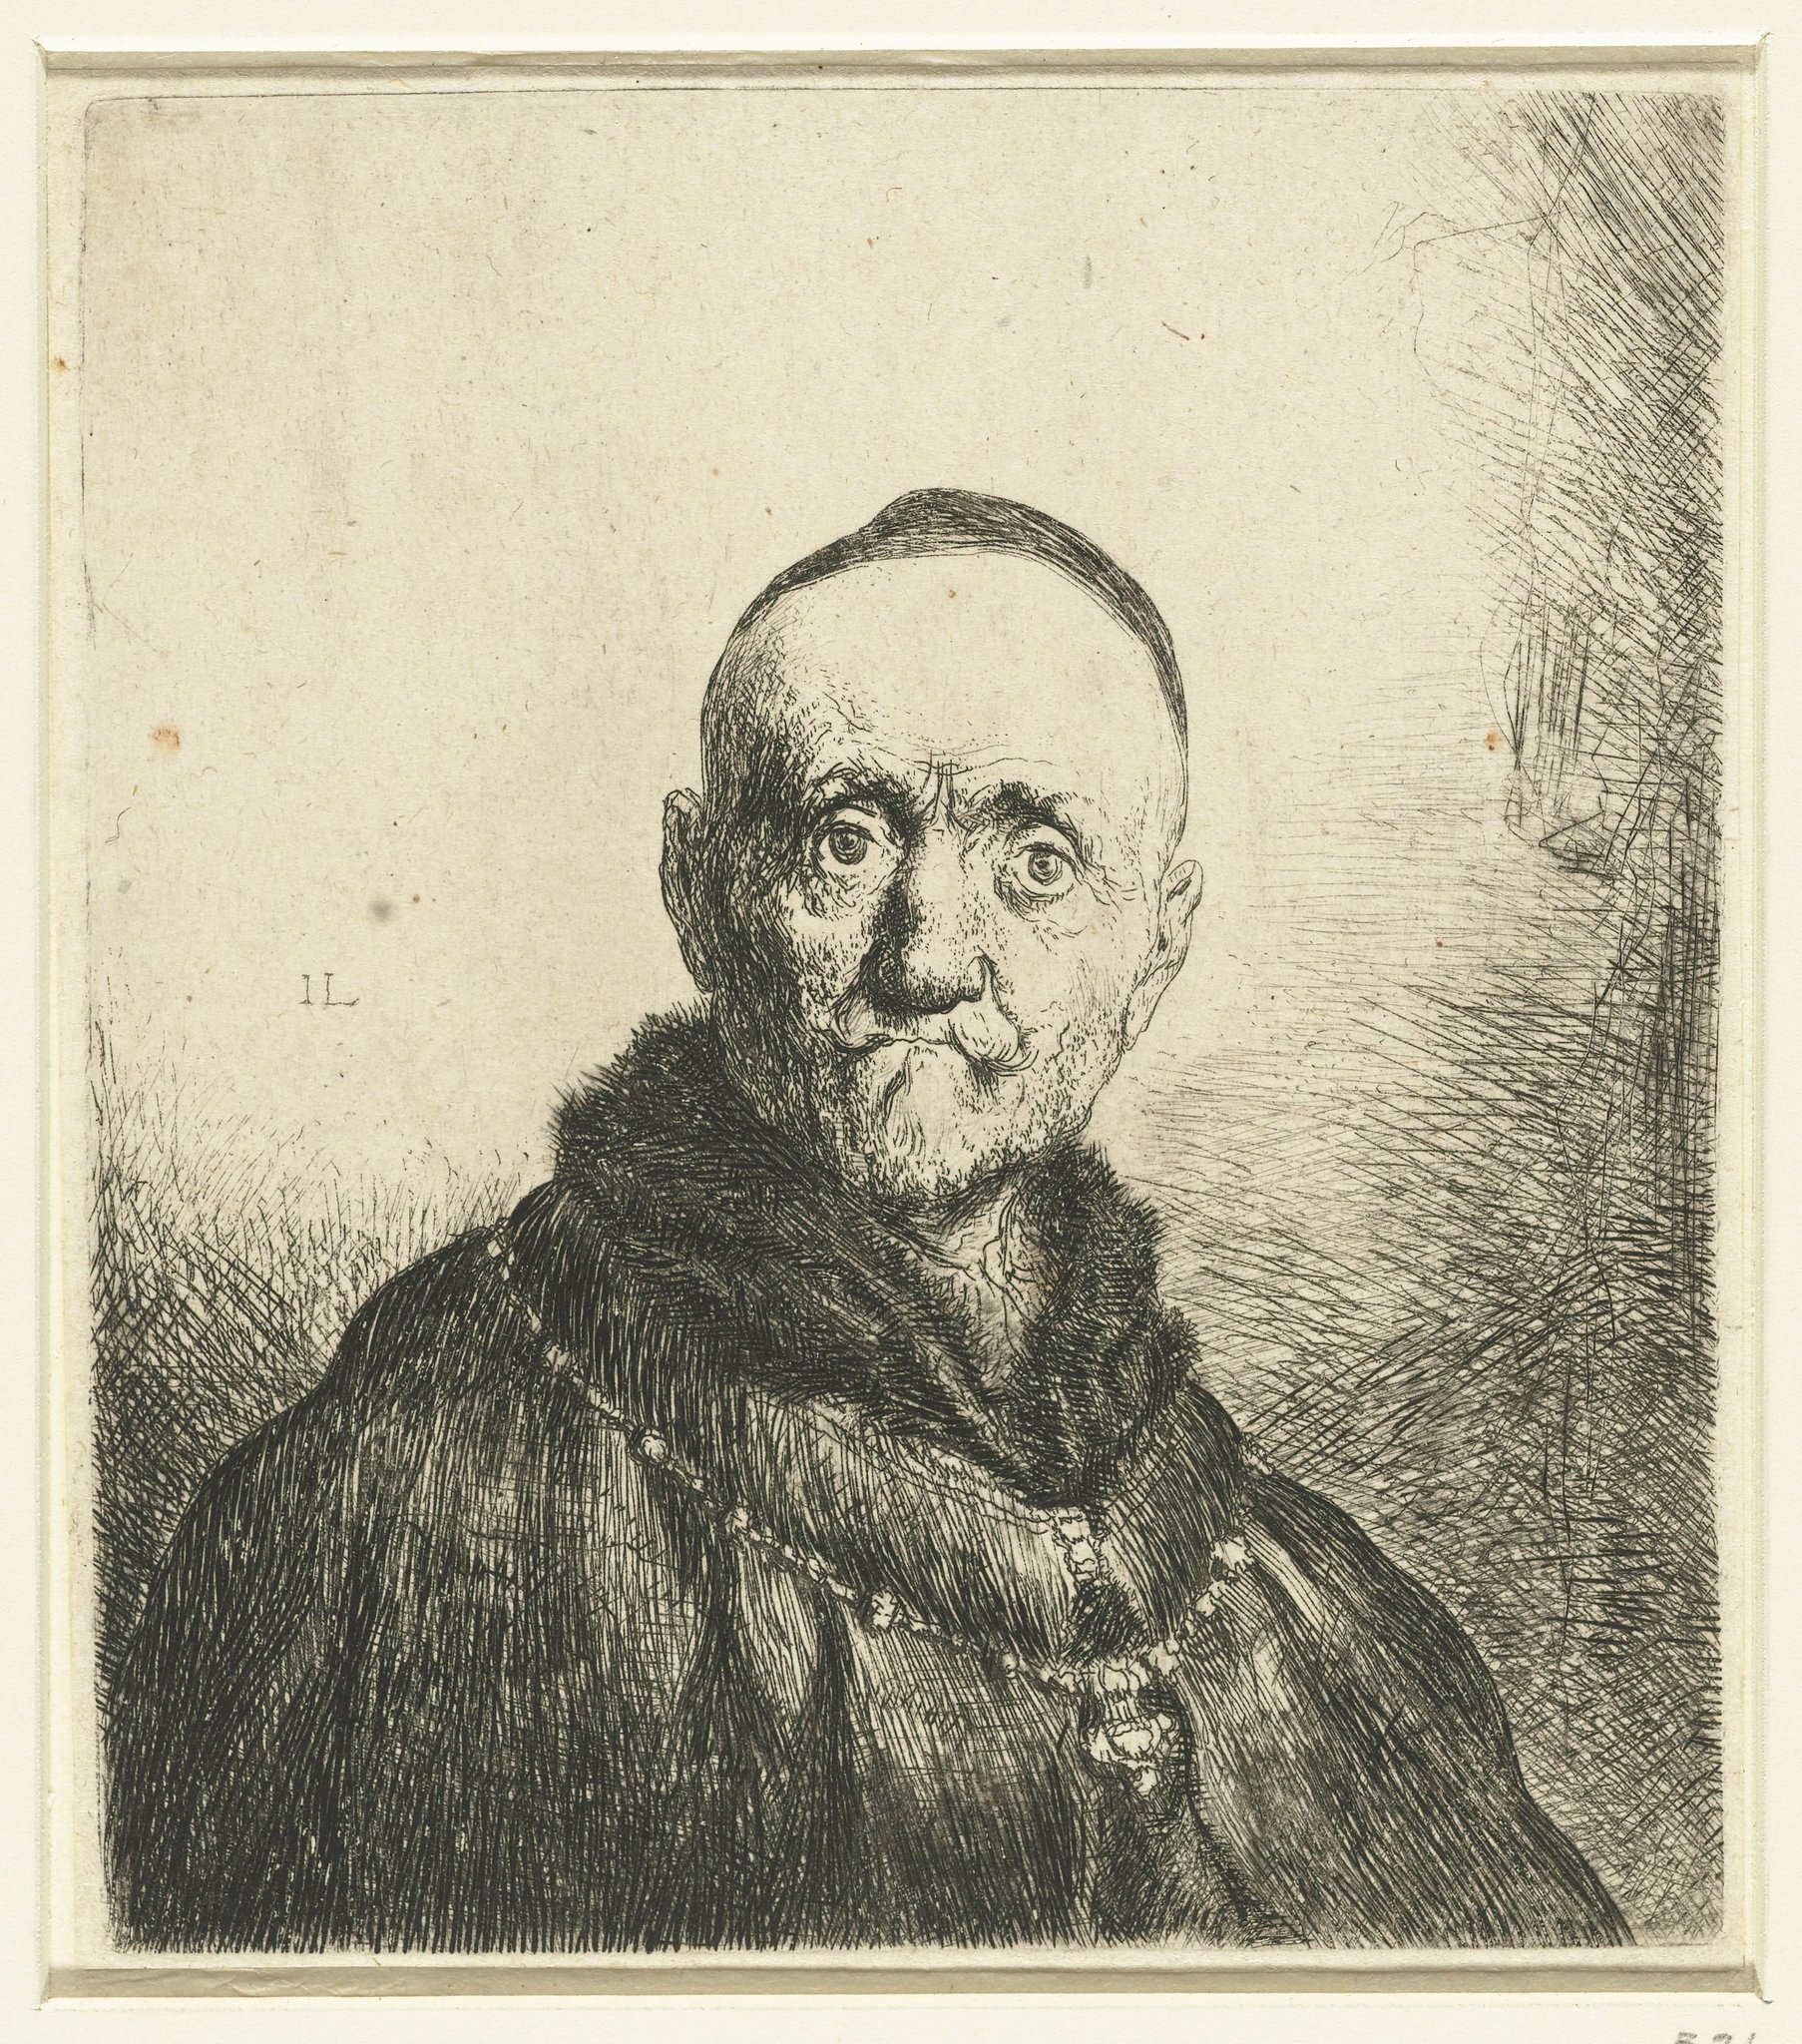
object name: print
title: Diverse tronikens geets van J. L.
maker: jan lievens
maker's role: draughtsman, painter, print maker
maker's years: 1607-1674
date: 1630-1632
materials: paper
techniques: etching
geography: leiden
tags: old man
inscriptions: collector's mark: Lugt 240